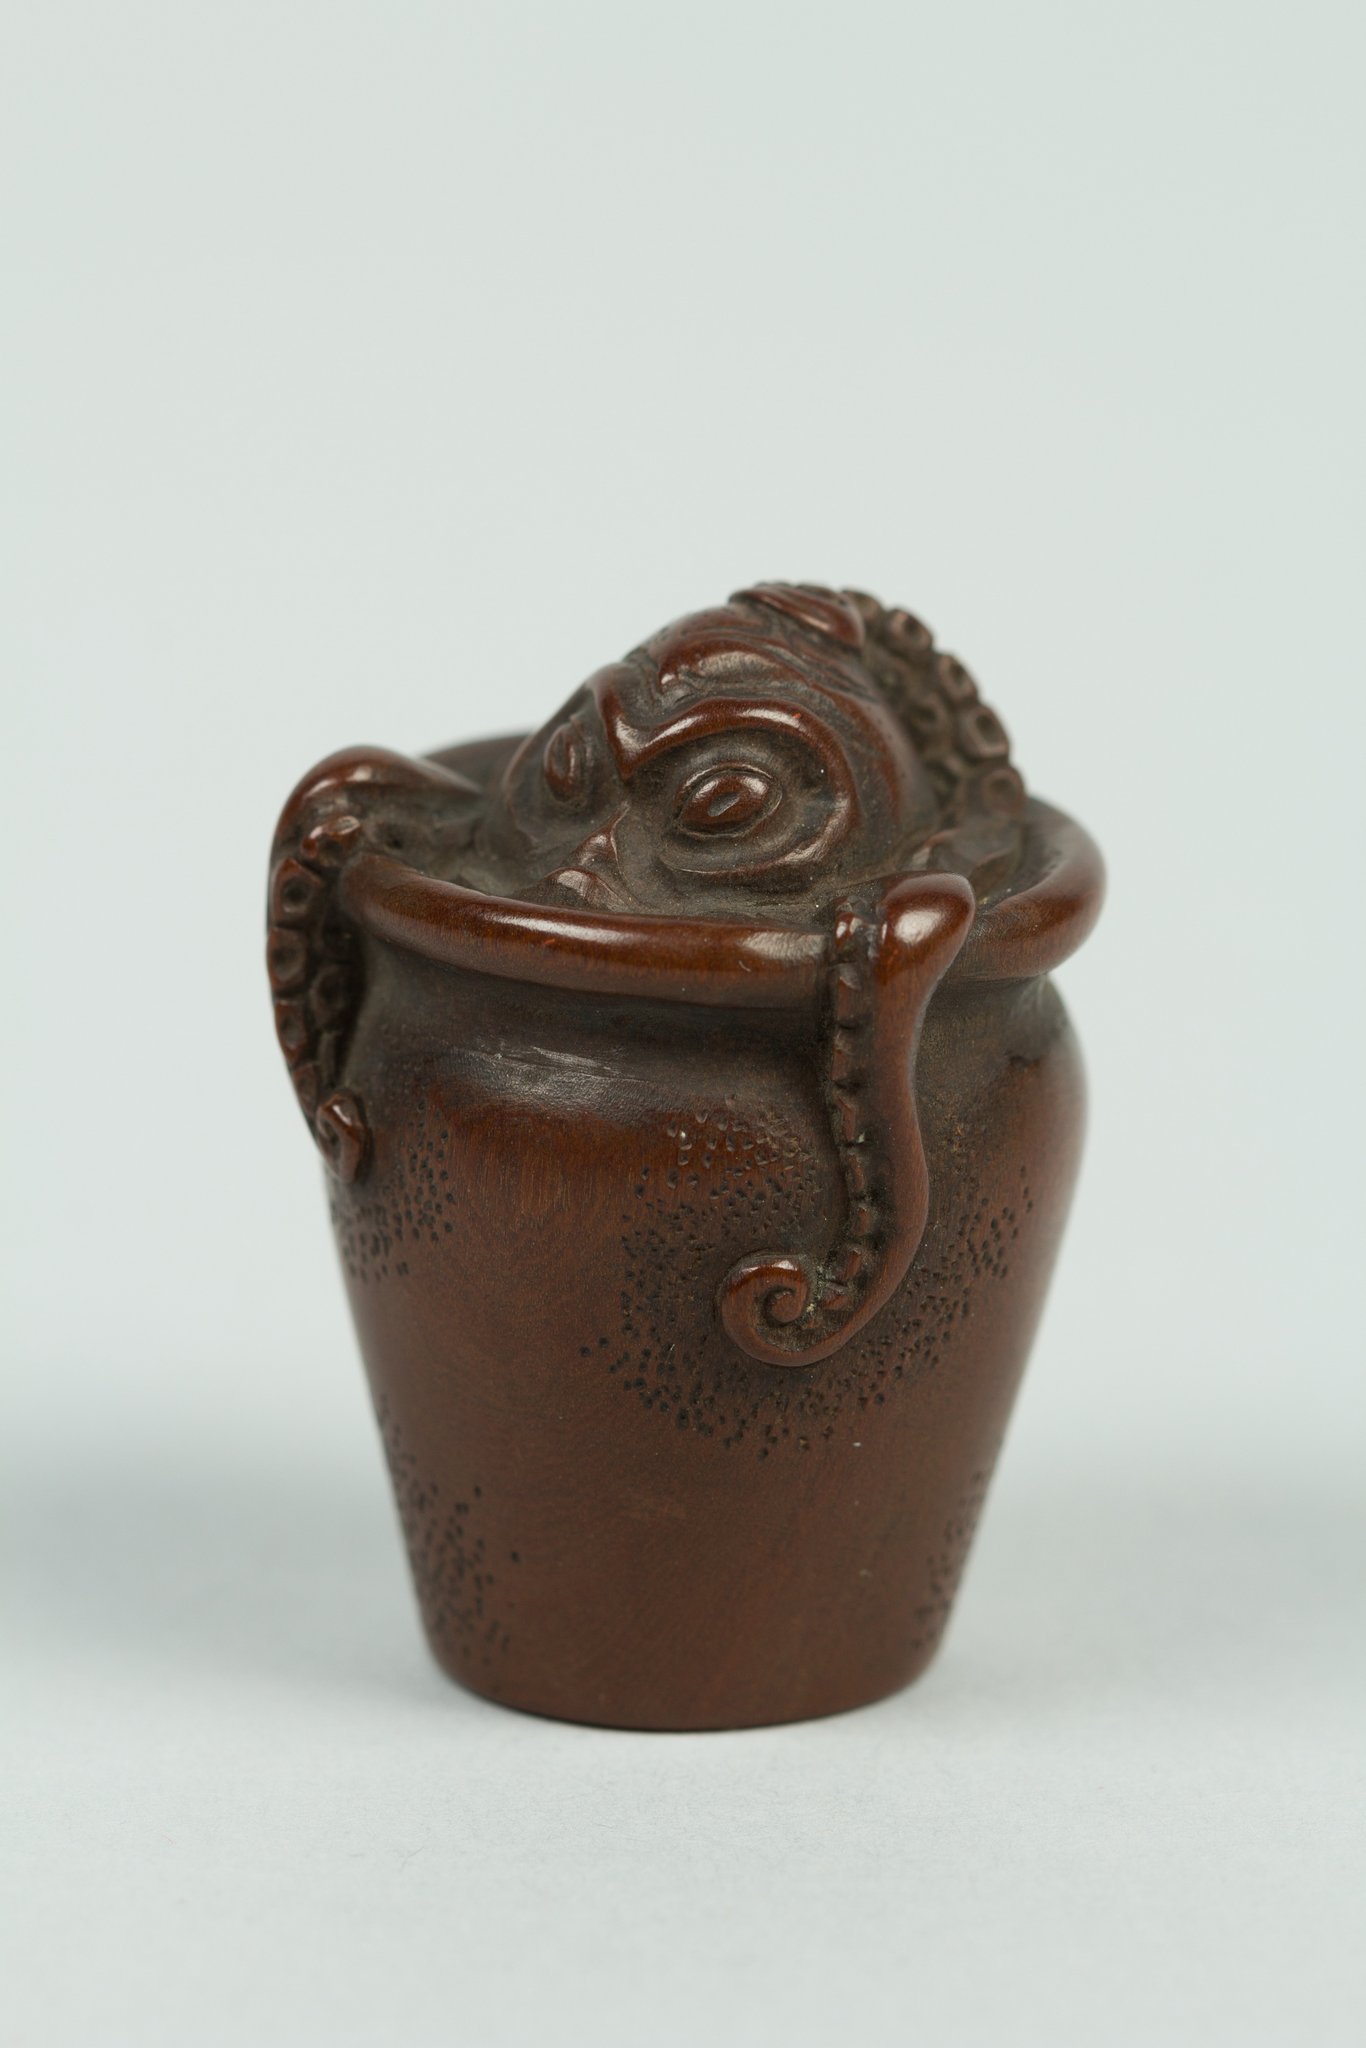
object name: netsuke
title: Netsuke of Octopus in a Pail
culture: japanese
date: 1701-1800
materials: wood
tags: octopus